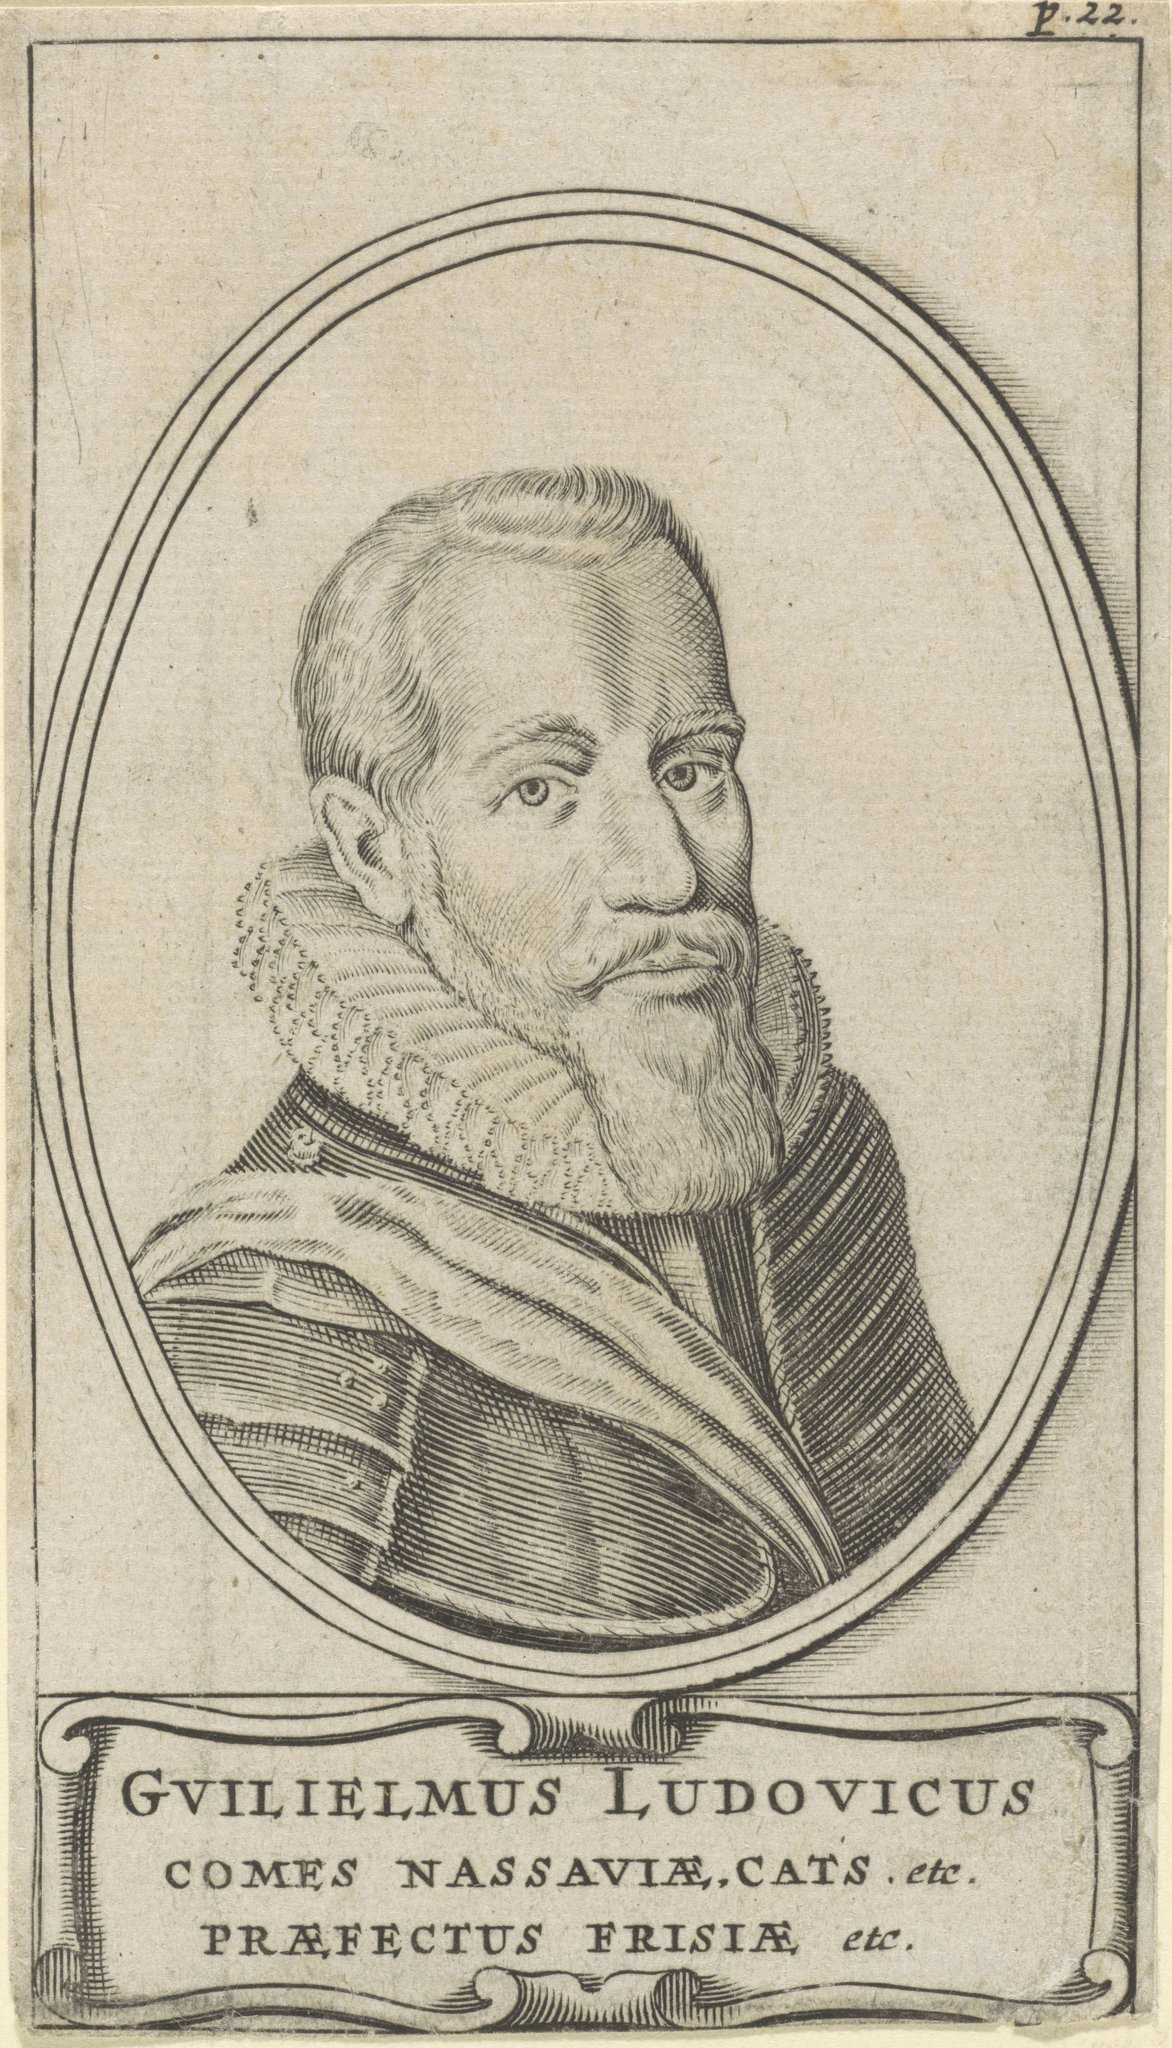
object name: print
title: Portret van Willem Lodewijk, graaf van Nassau-Dillenburg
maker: Anonymous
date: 1600-1699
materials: paper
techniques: engraving, etching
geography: low countries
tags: willem lodewijk graaf van nassau-dillenburg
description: De hier vermelde titel verwijst naar de hoogst verkregen titel van de geportretteerde, niet per se naar de titel die de geportretteerde op deze voorstelling draagt.